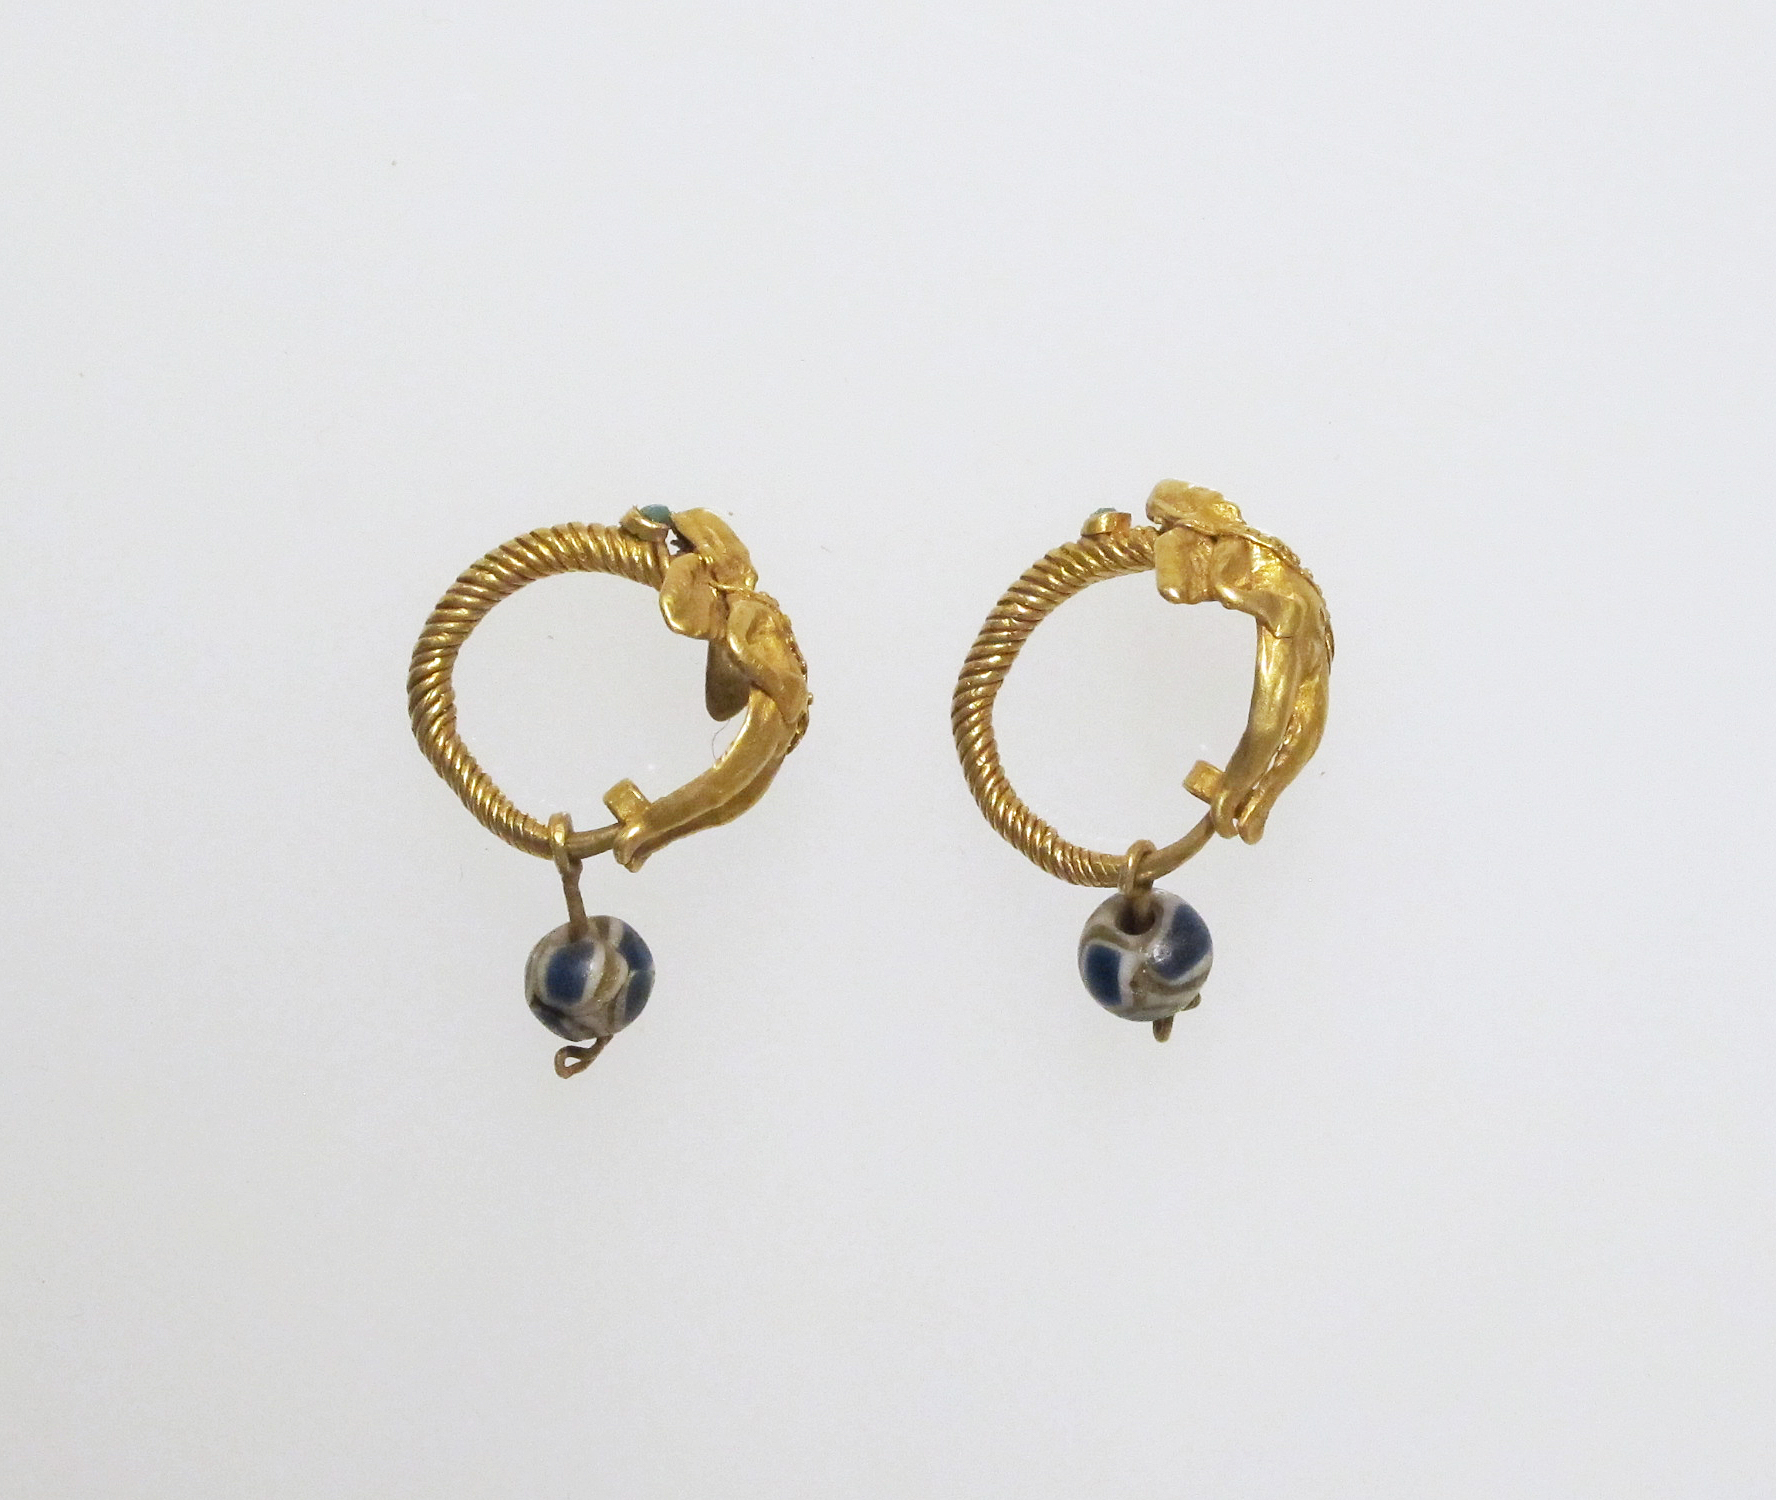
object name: earring with eros and paste bead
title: Earring with Eros and paste beads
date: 7000 BCE-330 CE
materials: glass, gold, paste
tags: eros